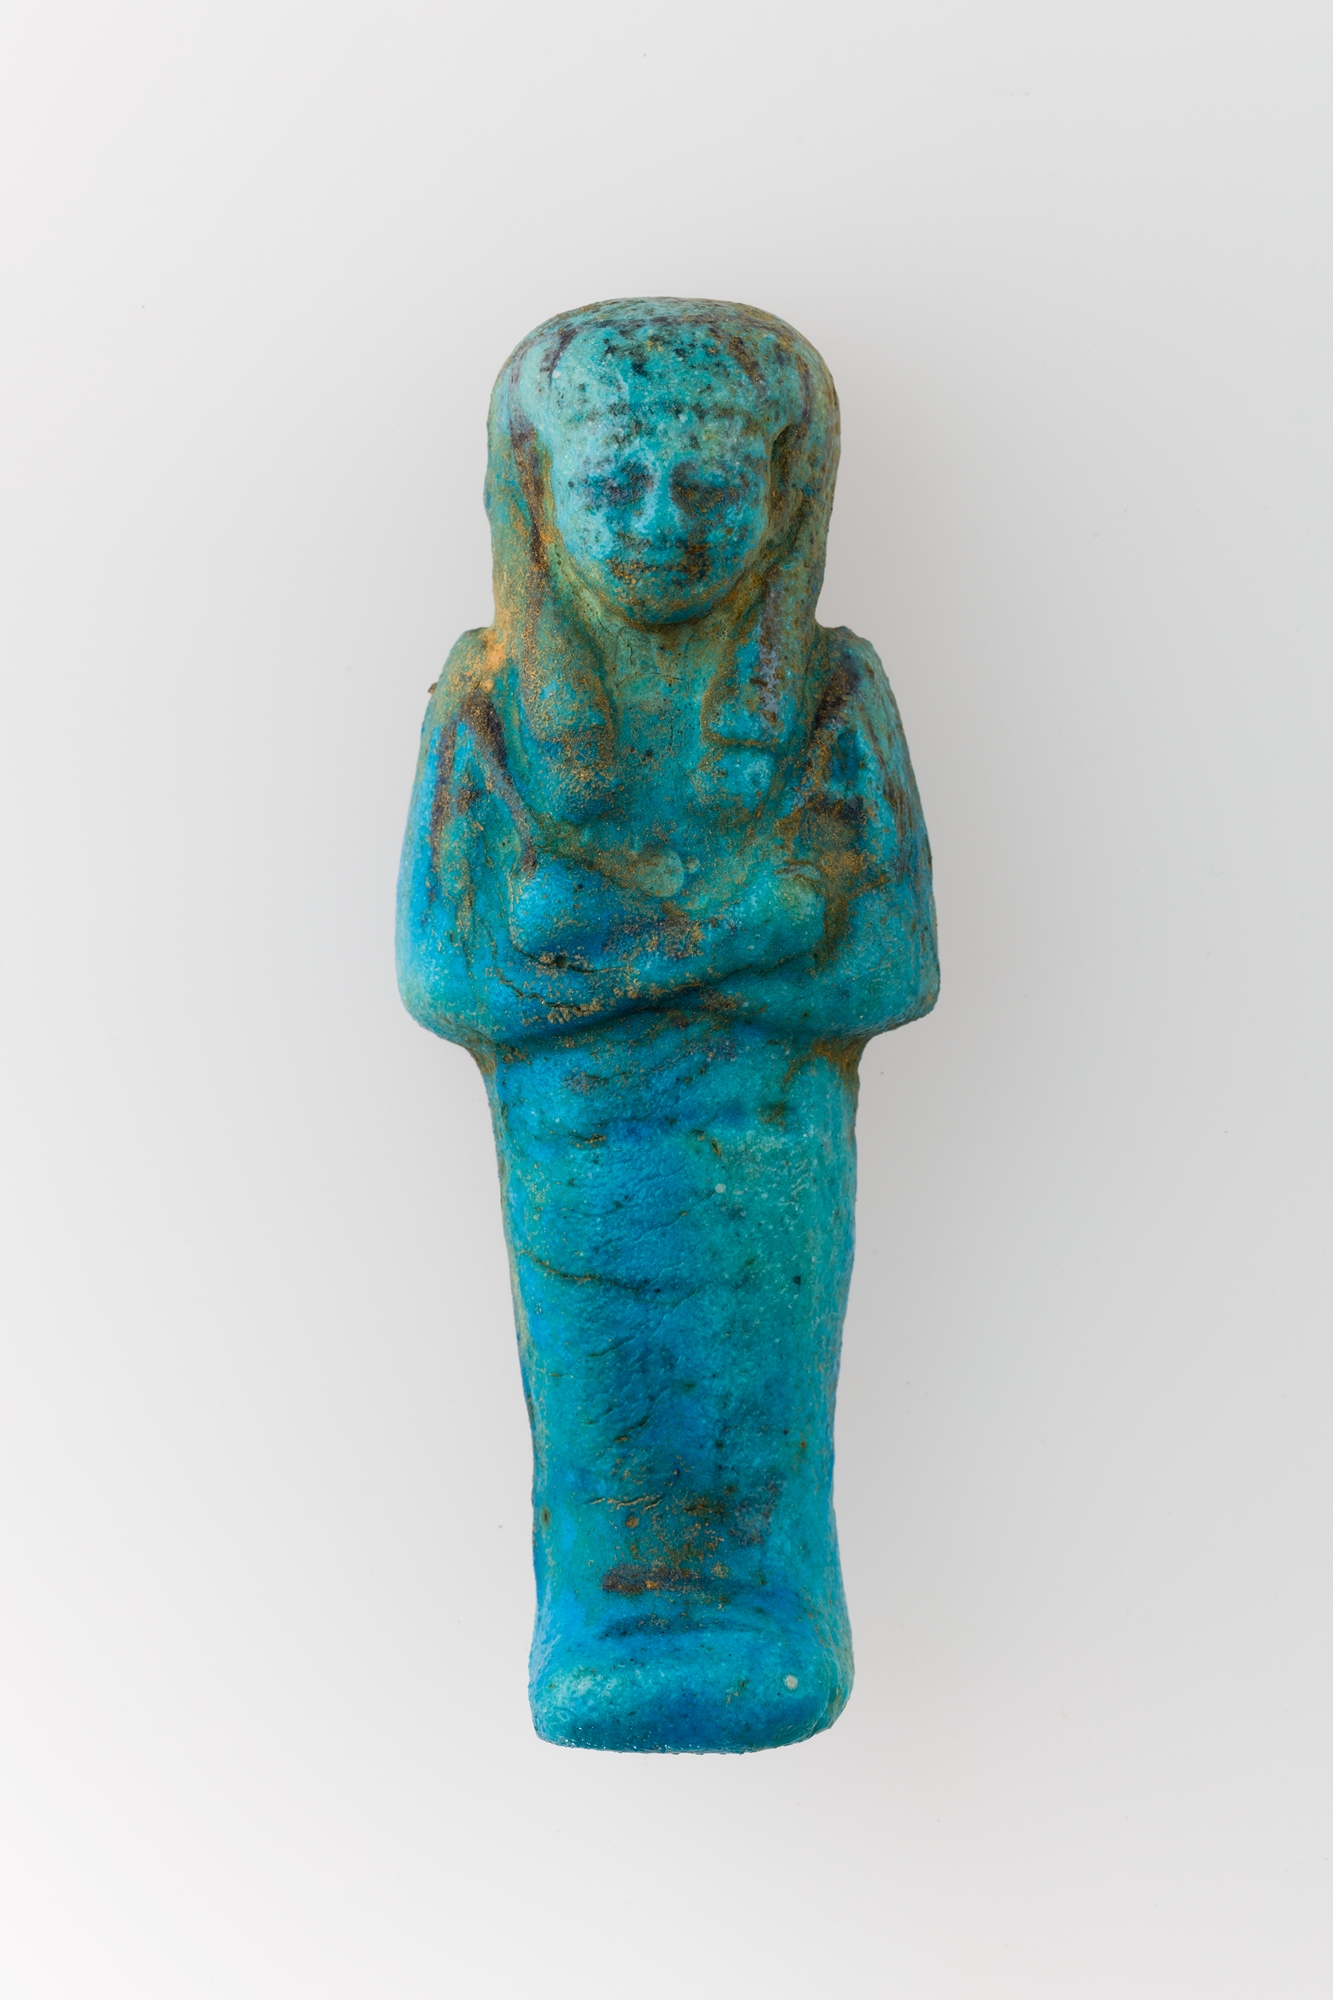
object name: shabti, henettawy c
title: Worker Shabti of Henettawy (C), Daughter of Isetemkheb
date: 990-970 BCE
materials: faience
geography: egypt